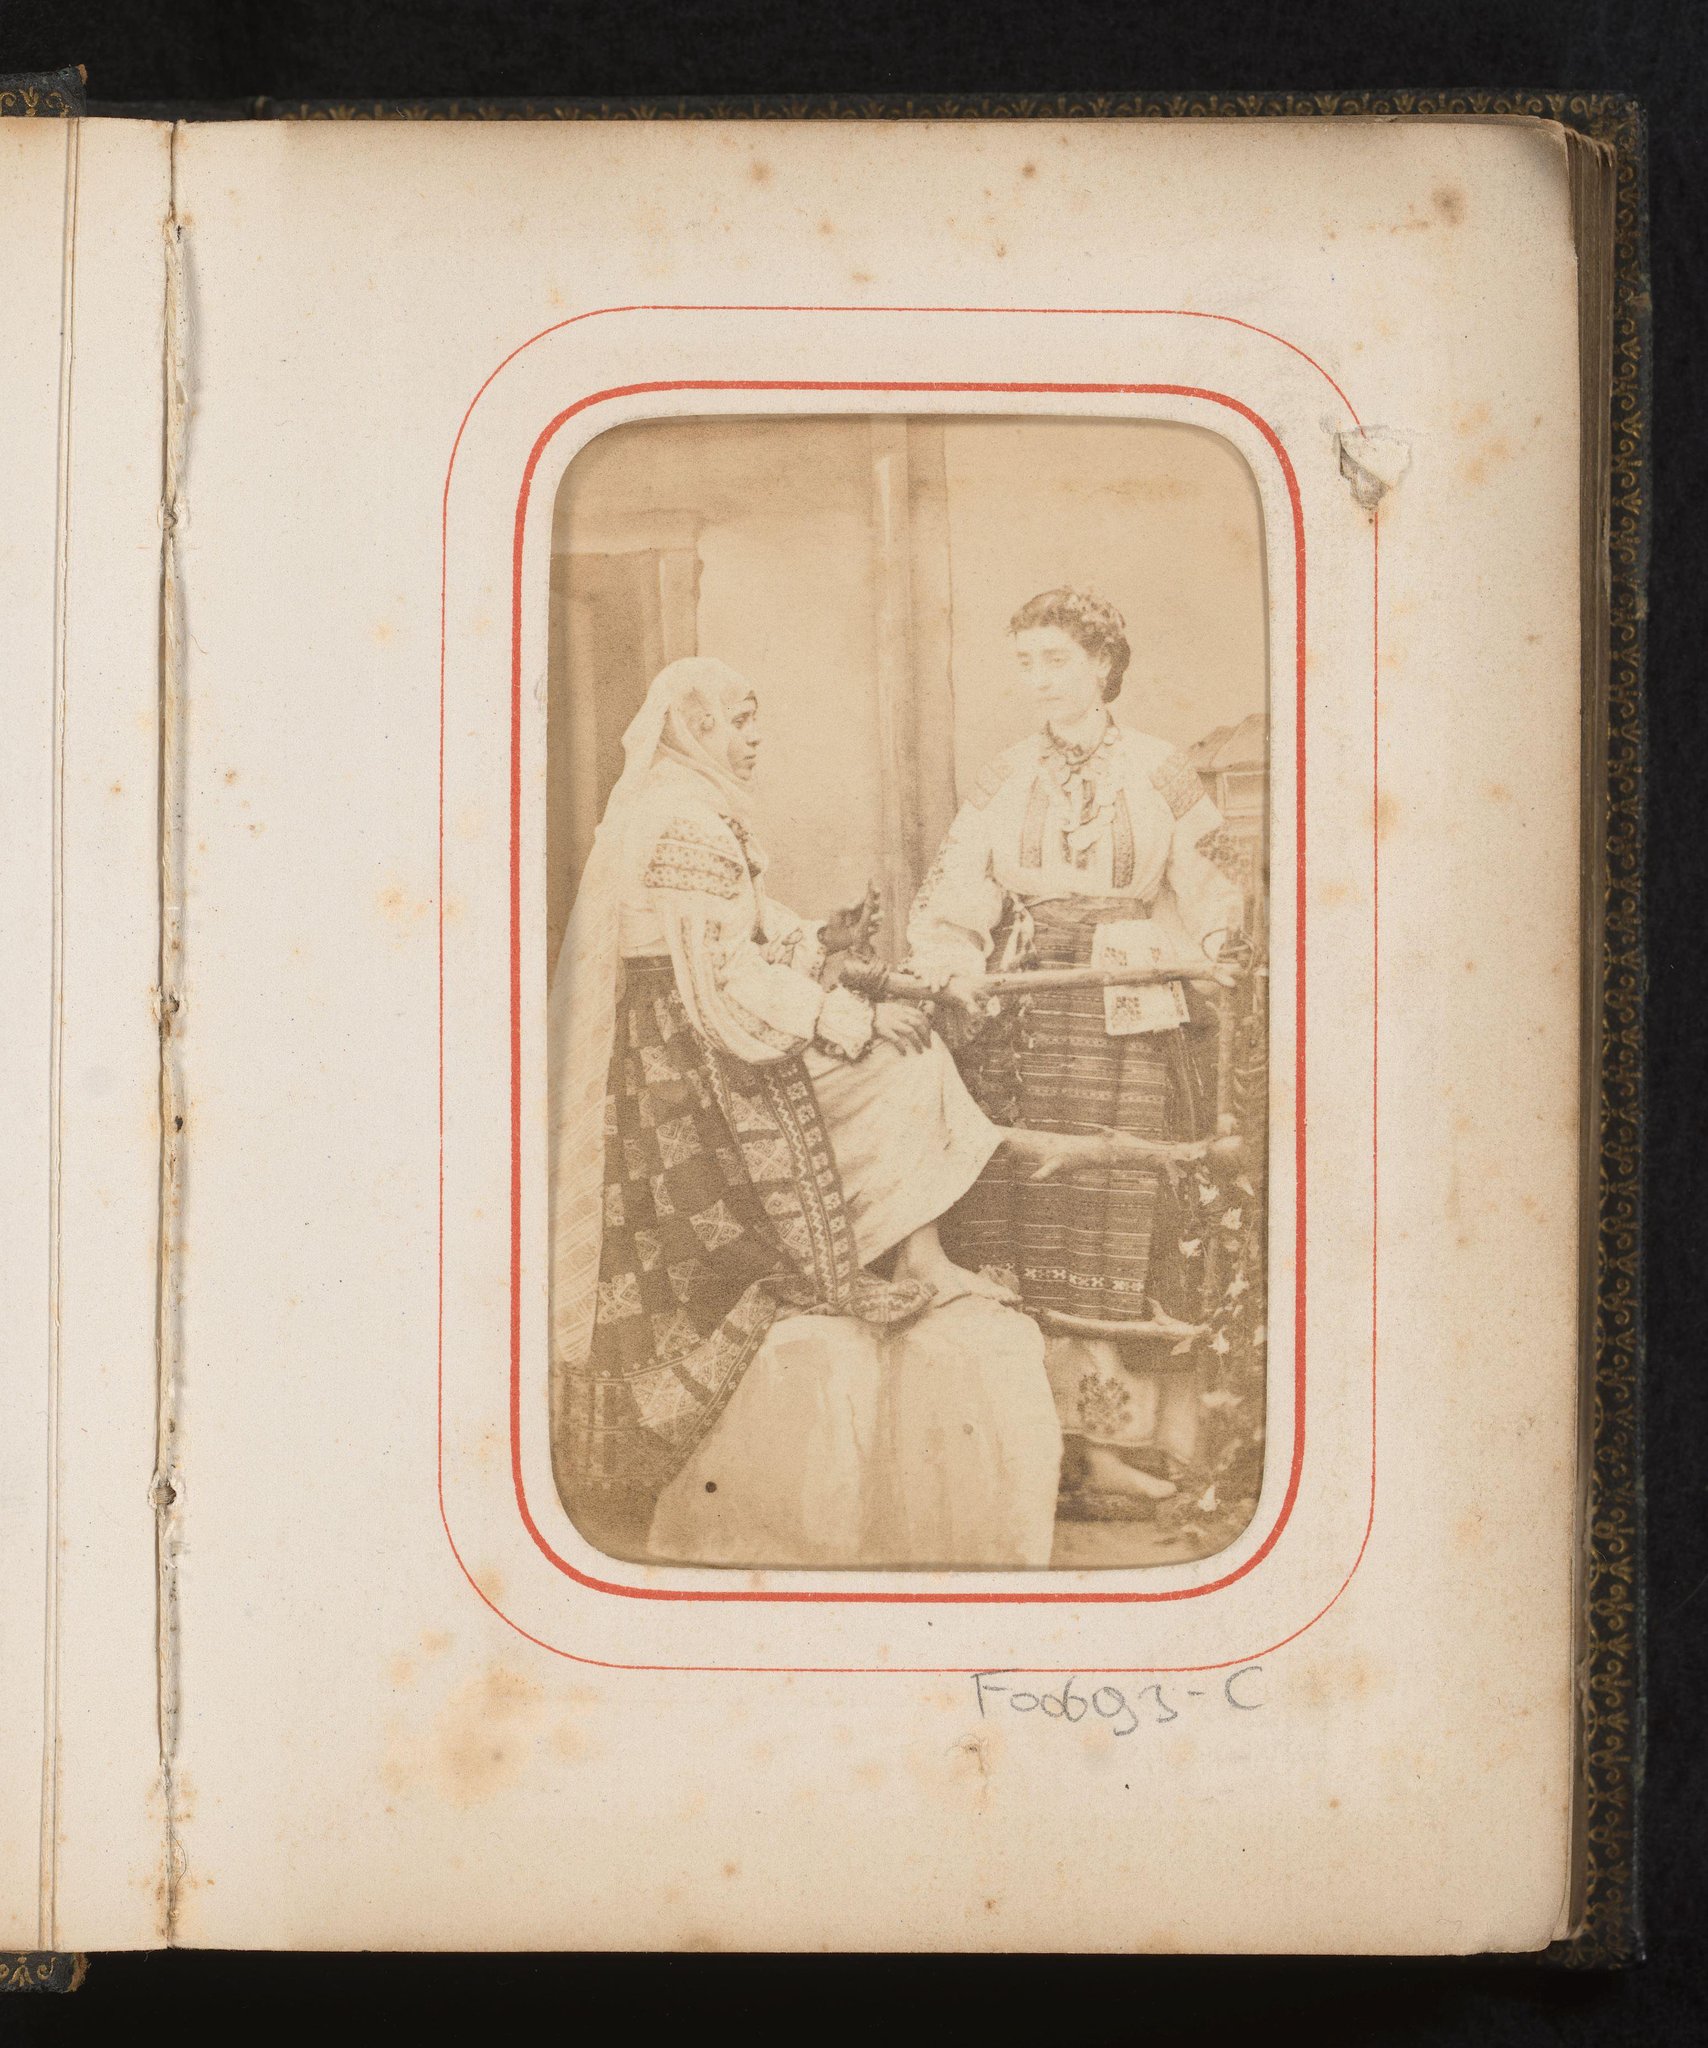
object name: album leaf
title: Portret van twee vrouwen in Roemeense klederdracht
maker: carol popp de szathmari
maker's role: fotograaf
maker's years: 1812-1887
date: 1870-1890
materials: cardboard, photographic support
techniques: albumen print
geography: bucharest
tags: historical persons - bb - woman, adult woman (+ two persons), folk costume, regional costume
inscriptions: inscription: ‘CHARLES SZATHMARI/ Peintre et Photographe de la Cour/ DE SALE PRINCE REGNANT/ des Principautées unies Roumaines./ (...)/ BUCAREST.’